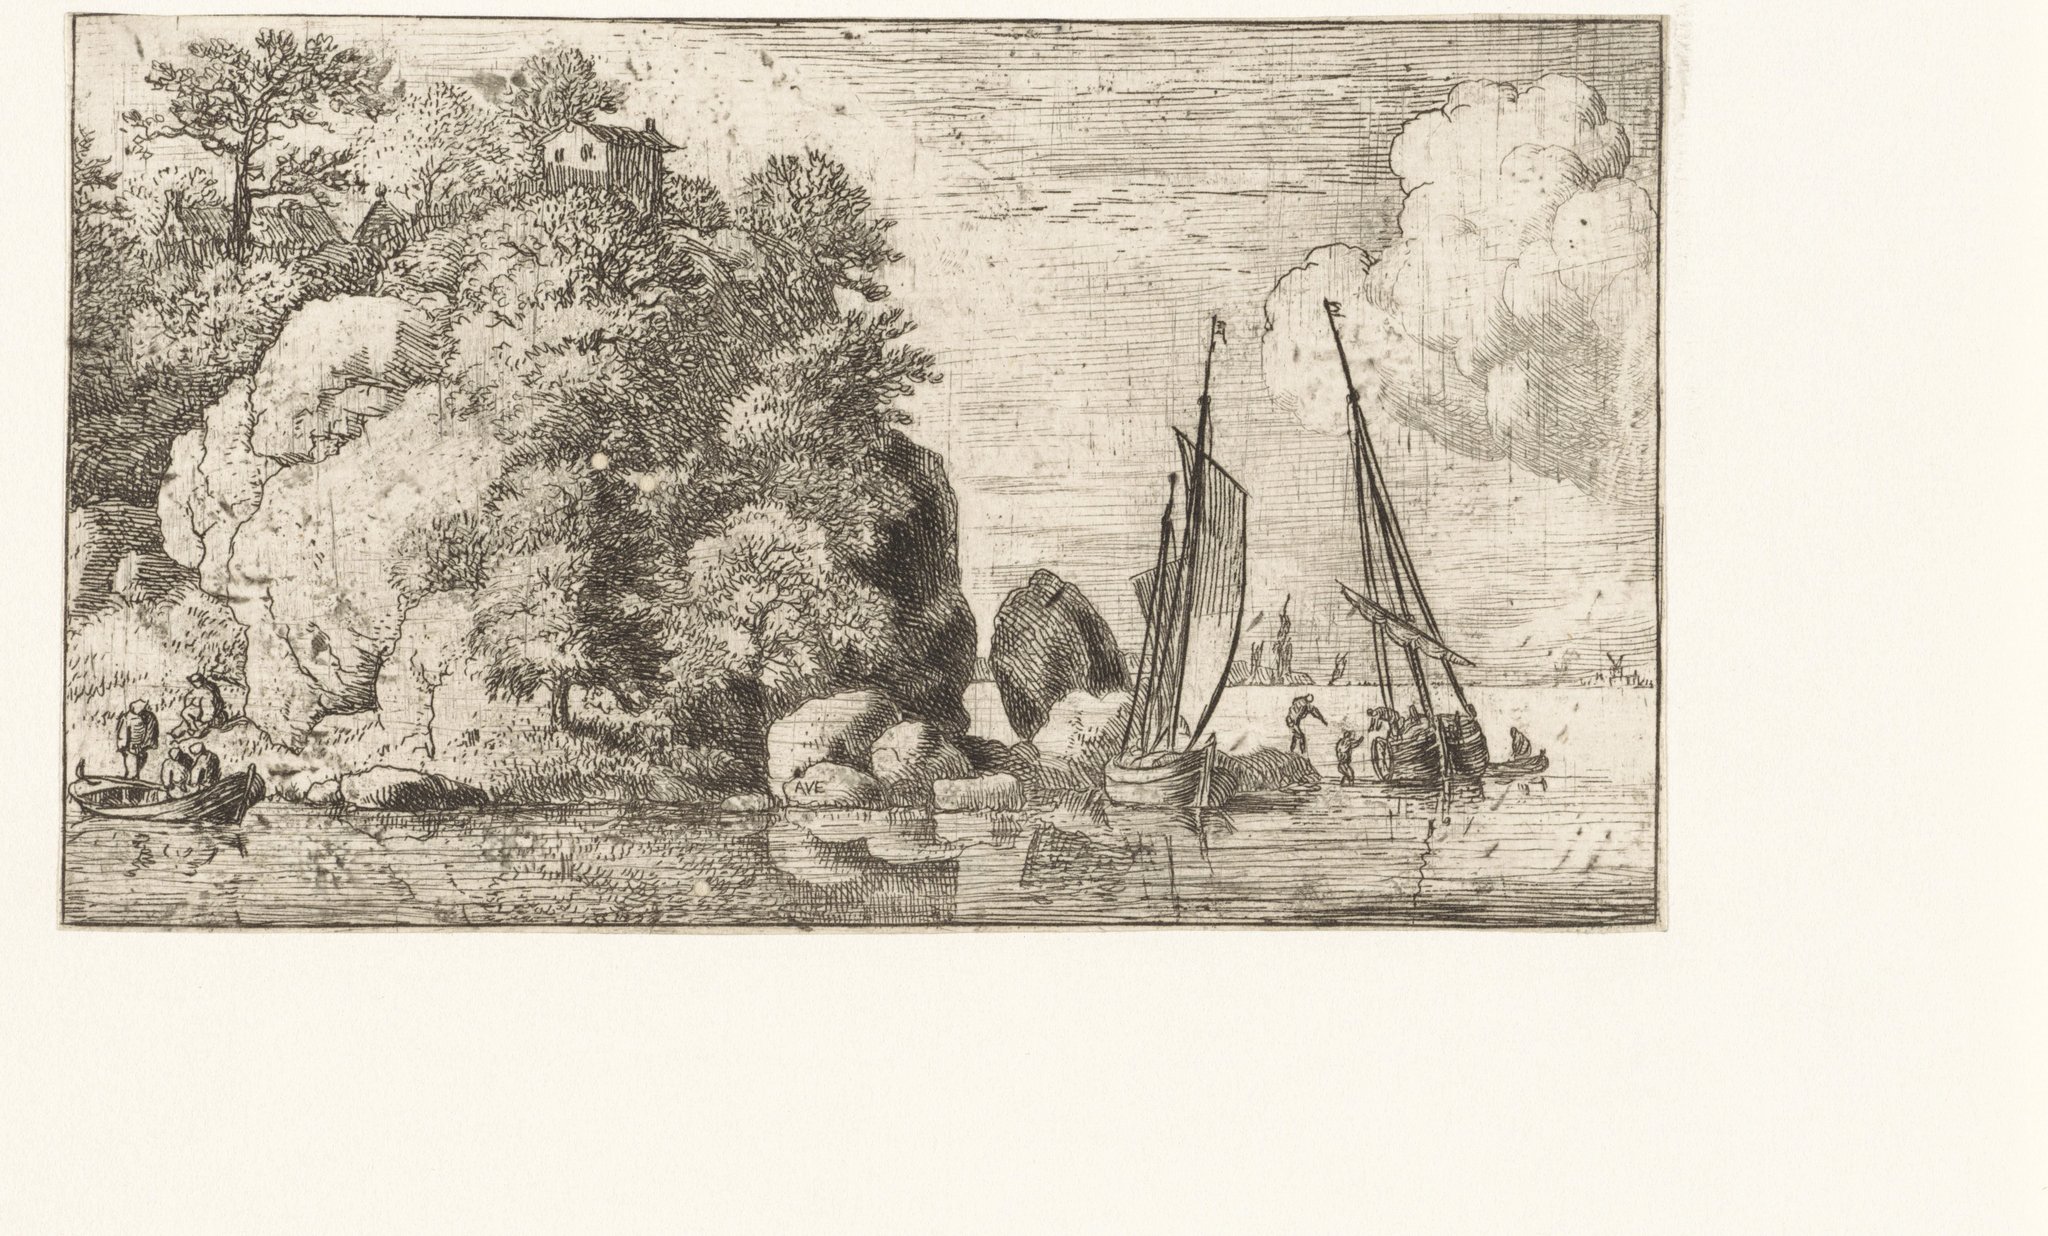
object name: print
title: Twee boten op een wijde rivier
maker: allaert van everdingen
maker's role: draughtsman, painter, print maker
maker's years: 1621-1675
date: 1631-1675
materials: paper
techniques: etching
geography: netherlands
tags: river (+ landscape with figures, staffage)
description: Gezicht op een hoge rots aan een rivier met twee boten. Op de rots een huisje en aan de voet van de rots vier personen en een roeiboot.